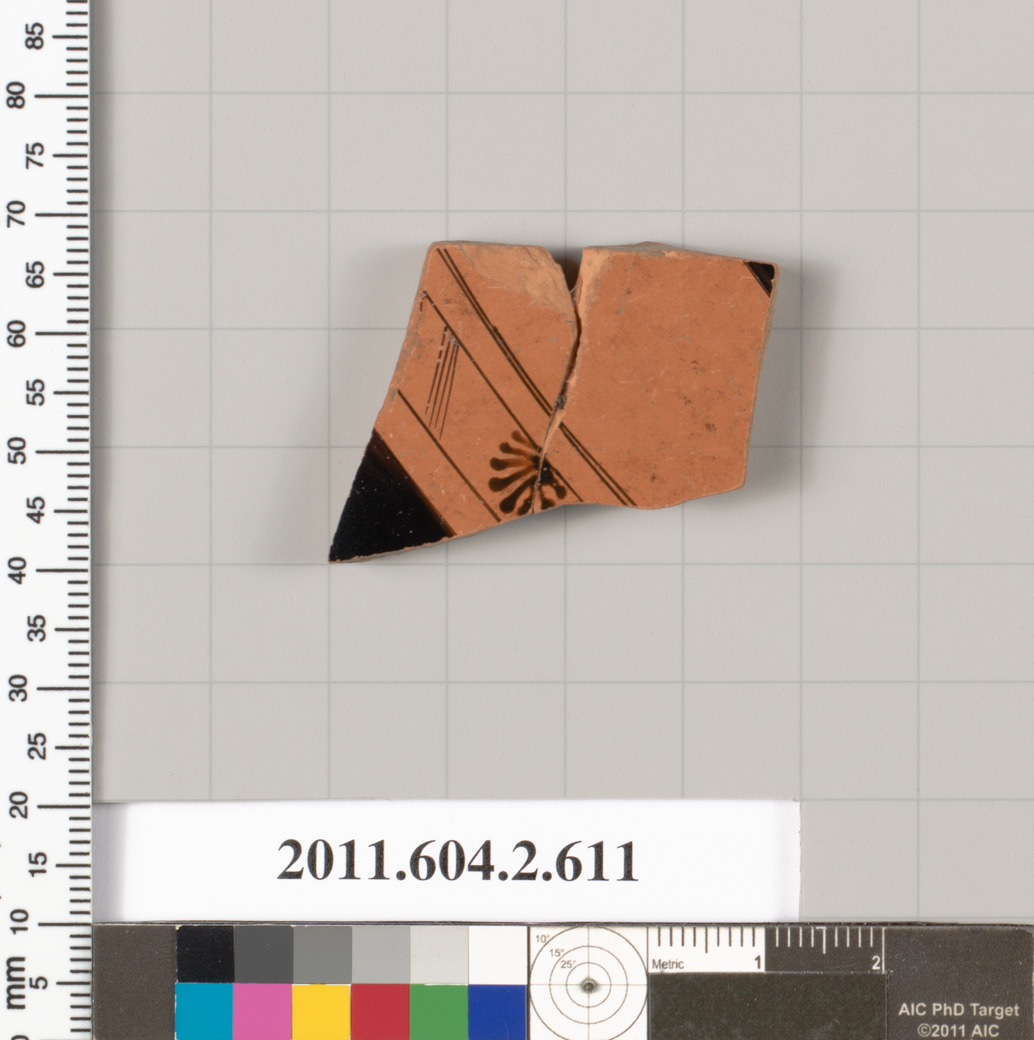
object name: column krater fragment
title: Terracotta fragment of a column-krater (bowl for mixing wine and water)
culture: greek, attic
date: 475-451 BCE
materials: terracotta